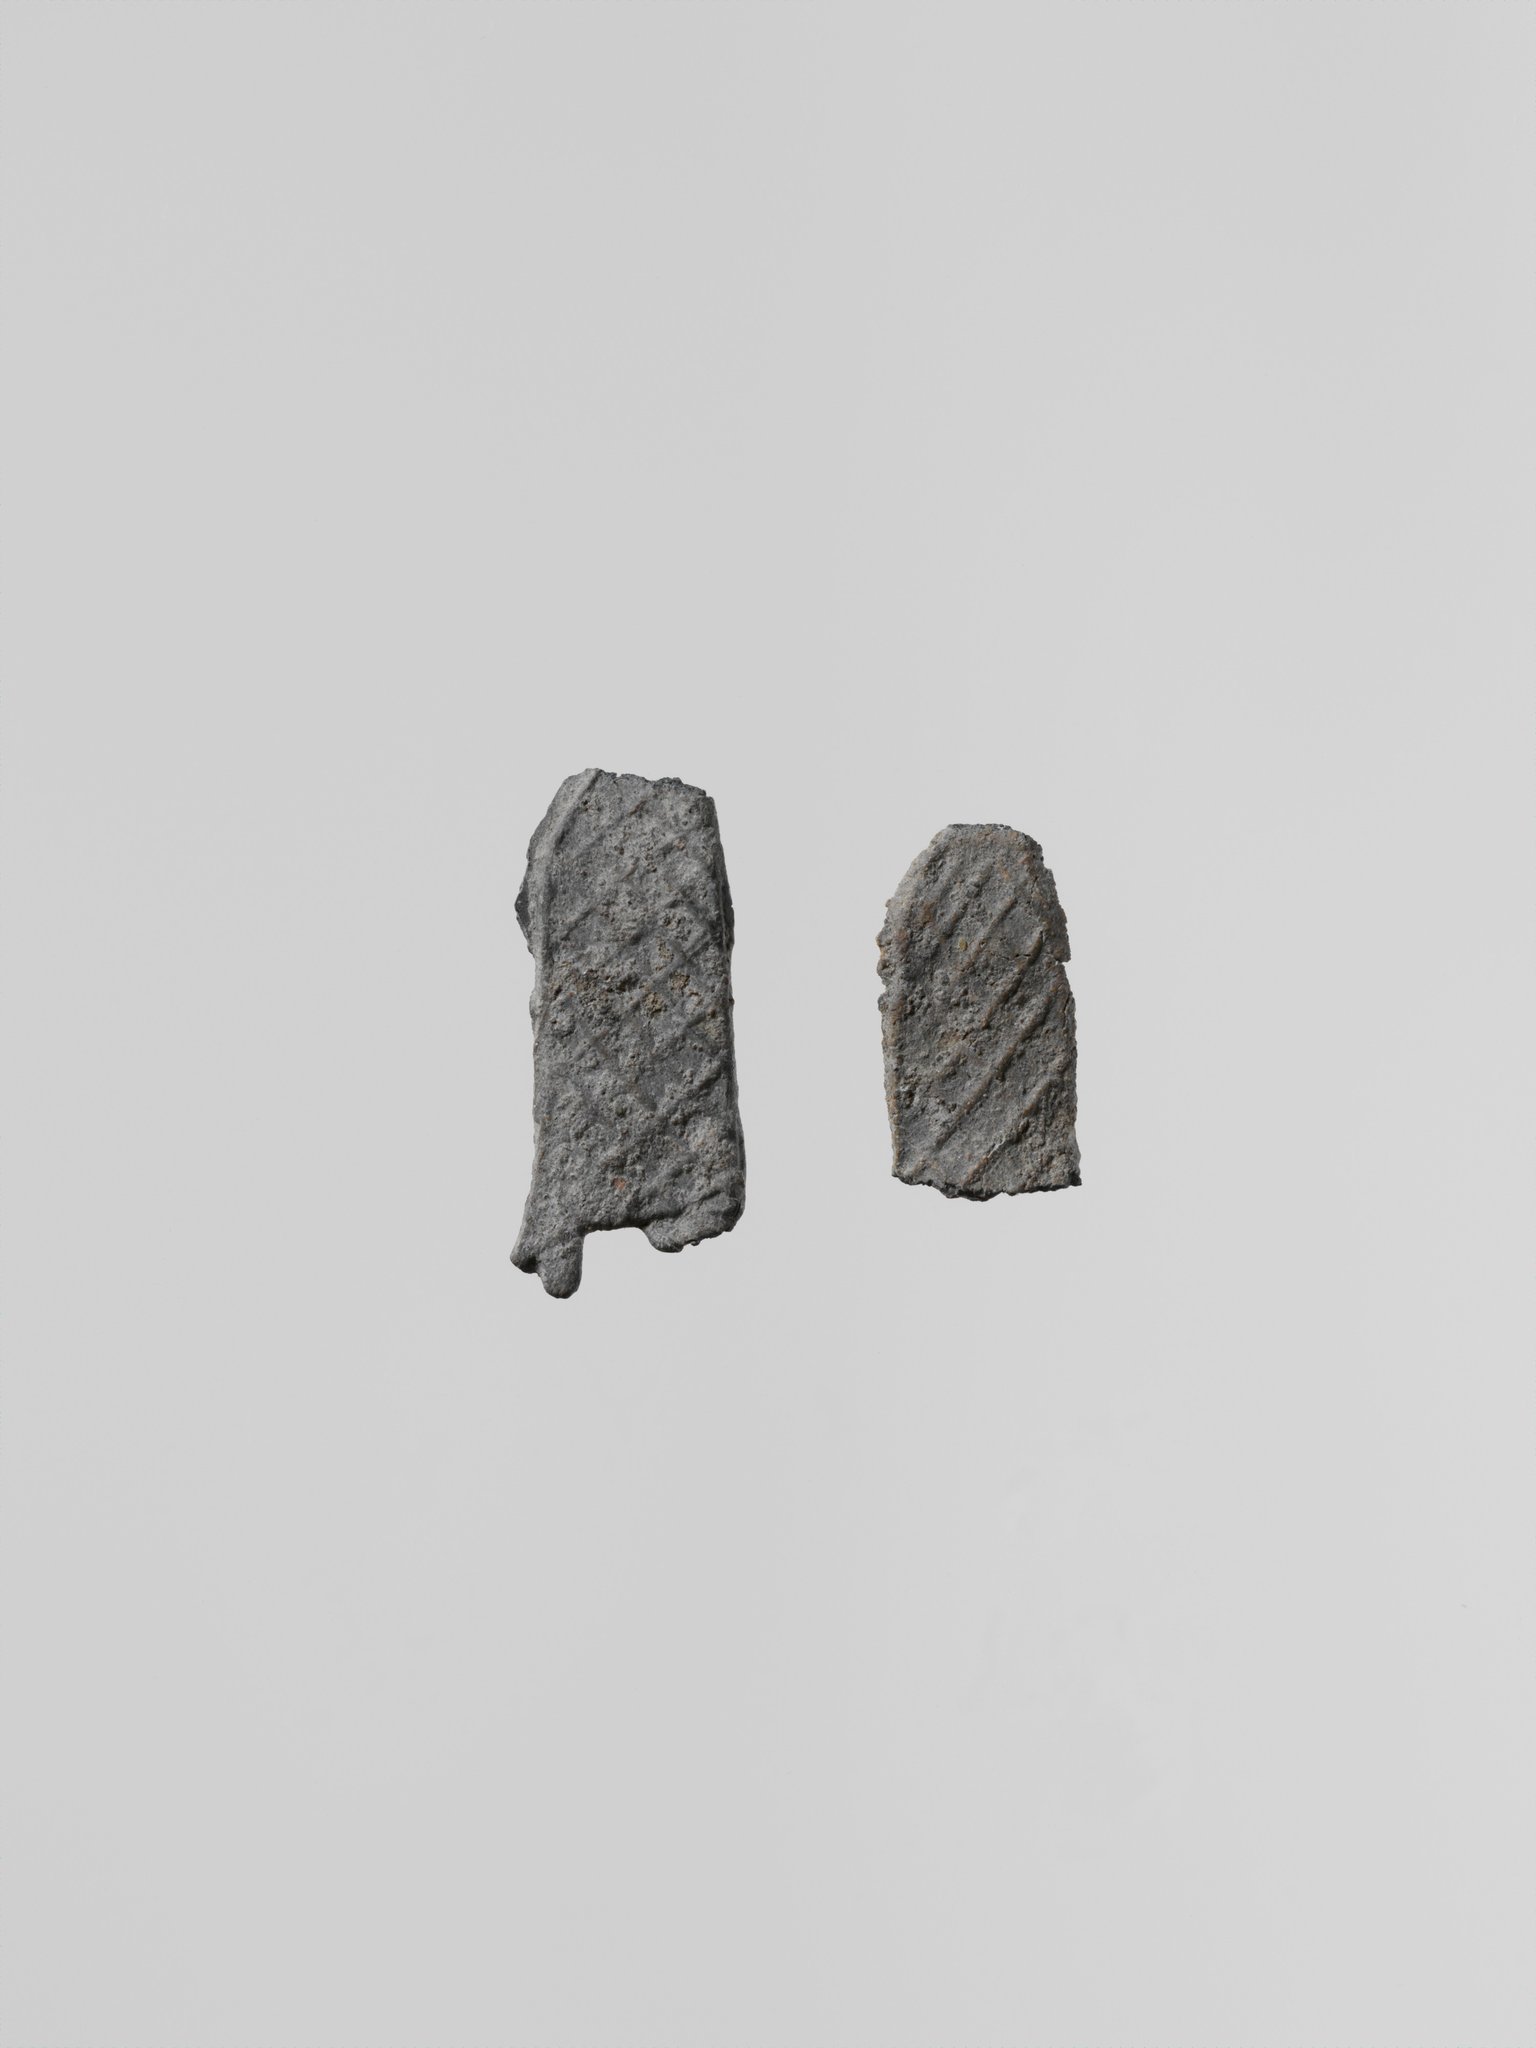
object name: statuette of a woman votary, 5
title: Statuette of a woman votary, 5 ?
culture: greek, laconian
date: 700-500 BCE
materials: lead